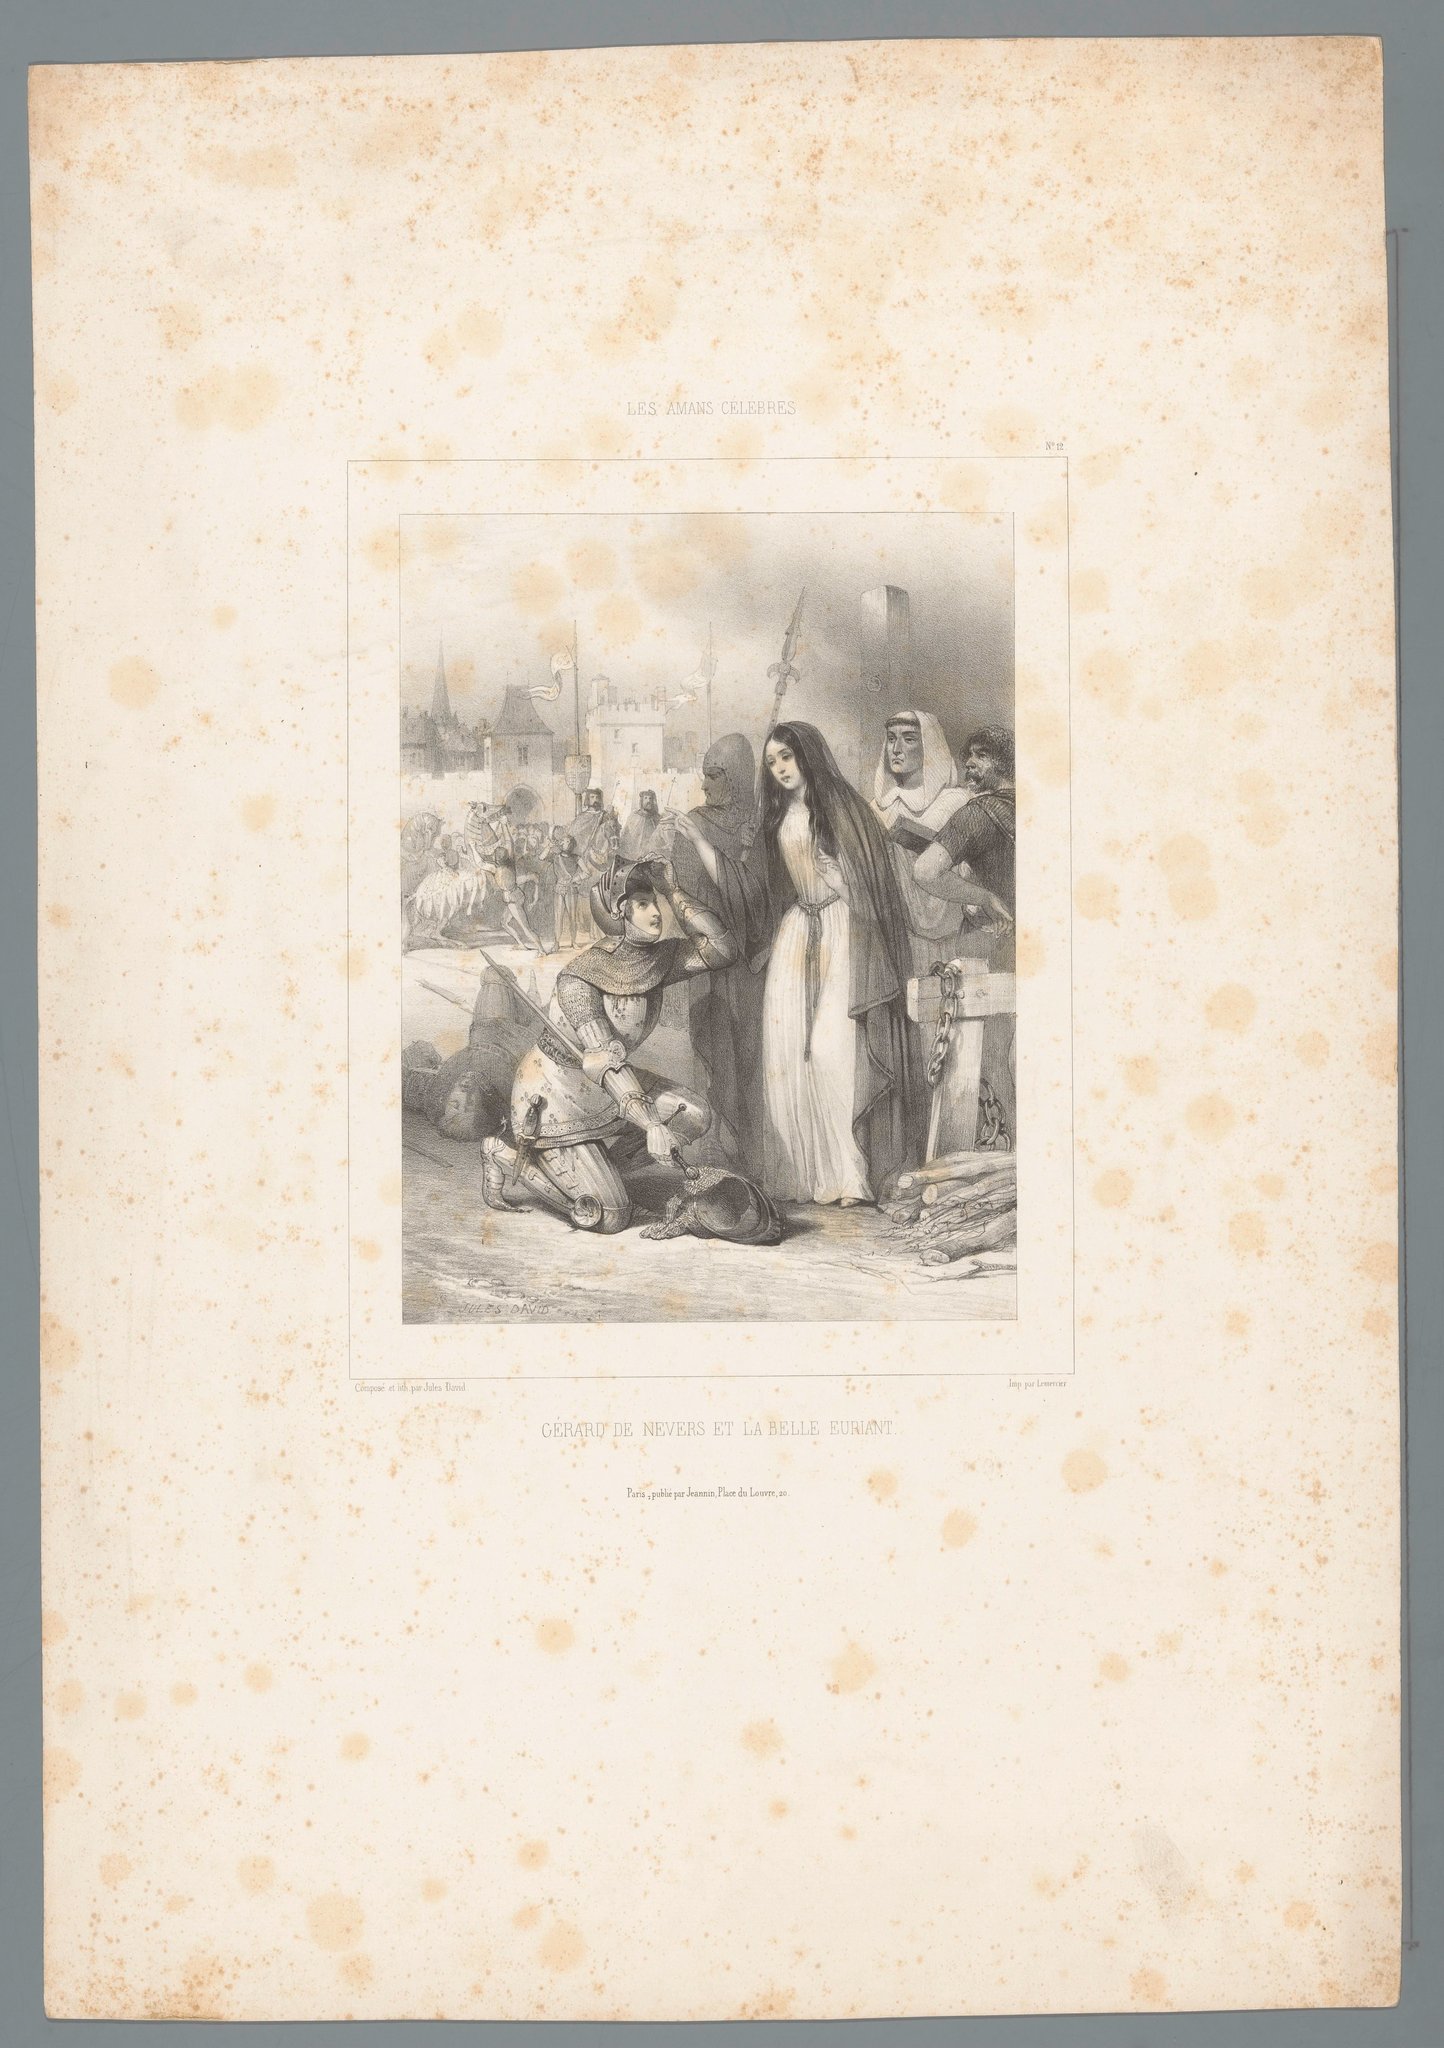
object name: print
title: Gerard van Nevers en Euryant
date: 1841-1843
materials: paper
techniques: lithograph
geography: paris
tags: couple of lovers, knight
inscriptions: collector's mark: Lugt 2228a, check stamp: Lugt 1397c, check stamp: Lugt 3903